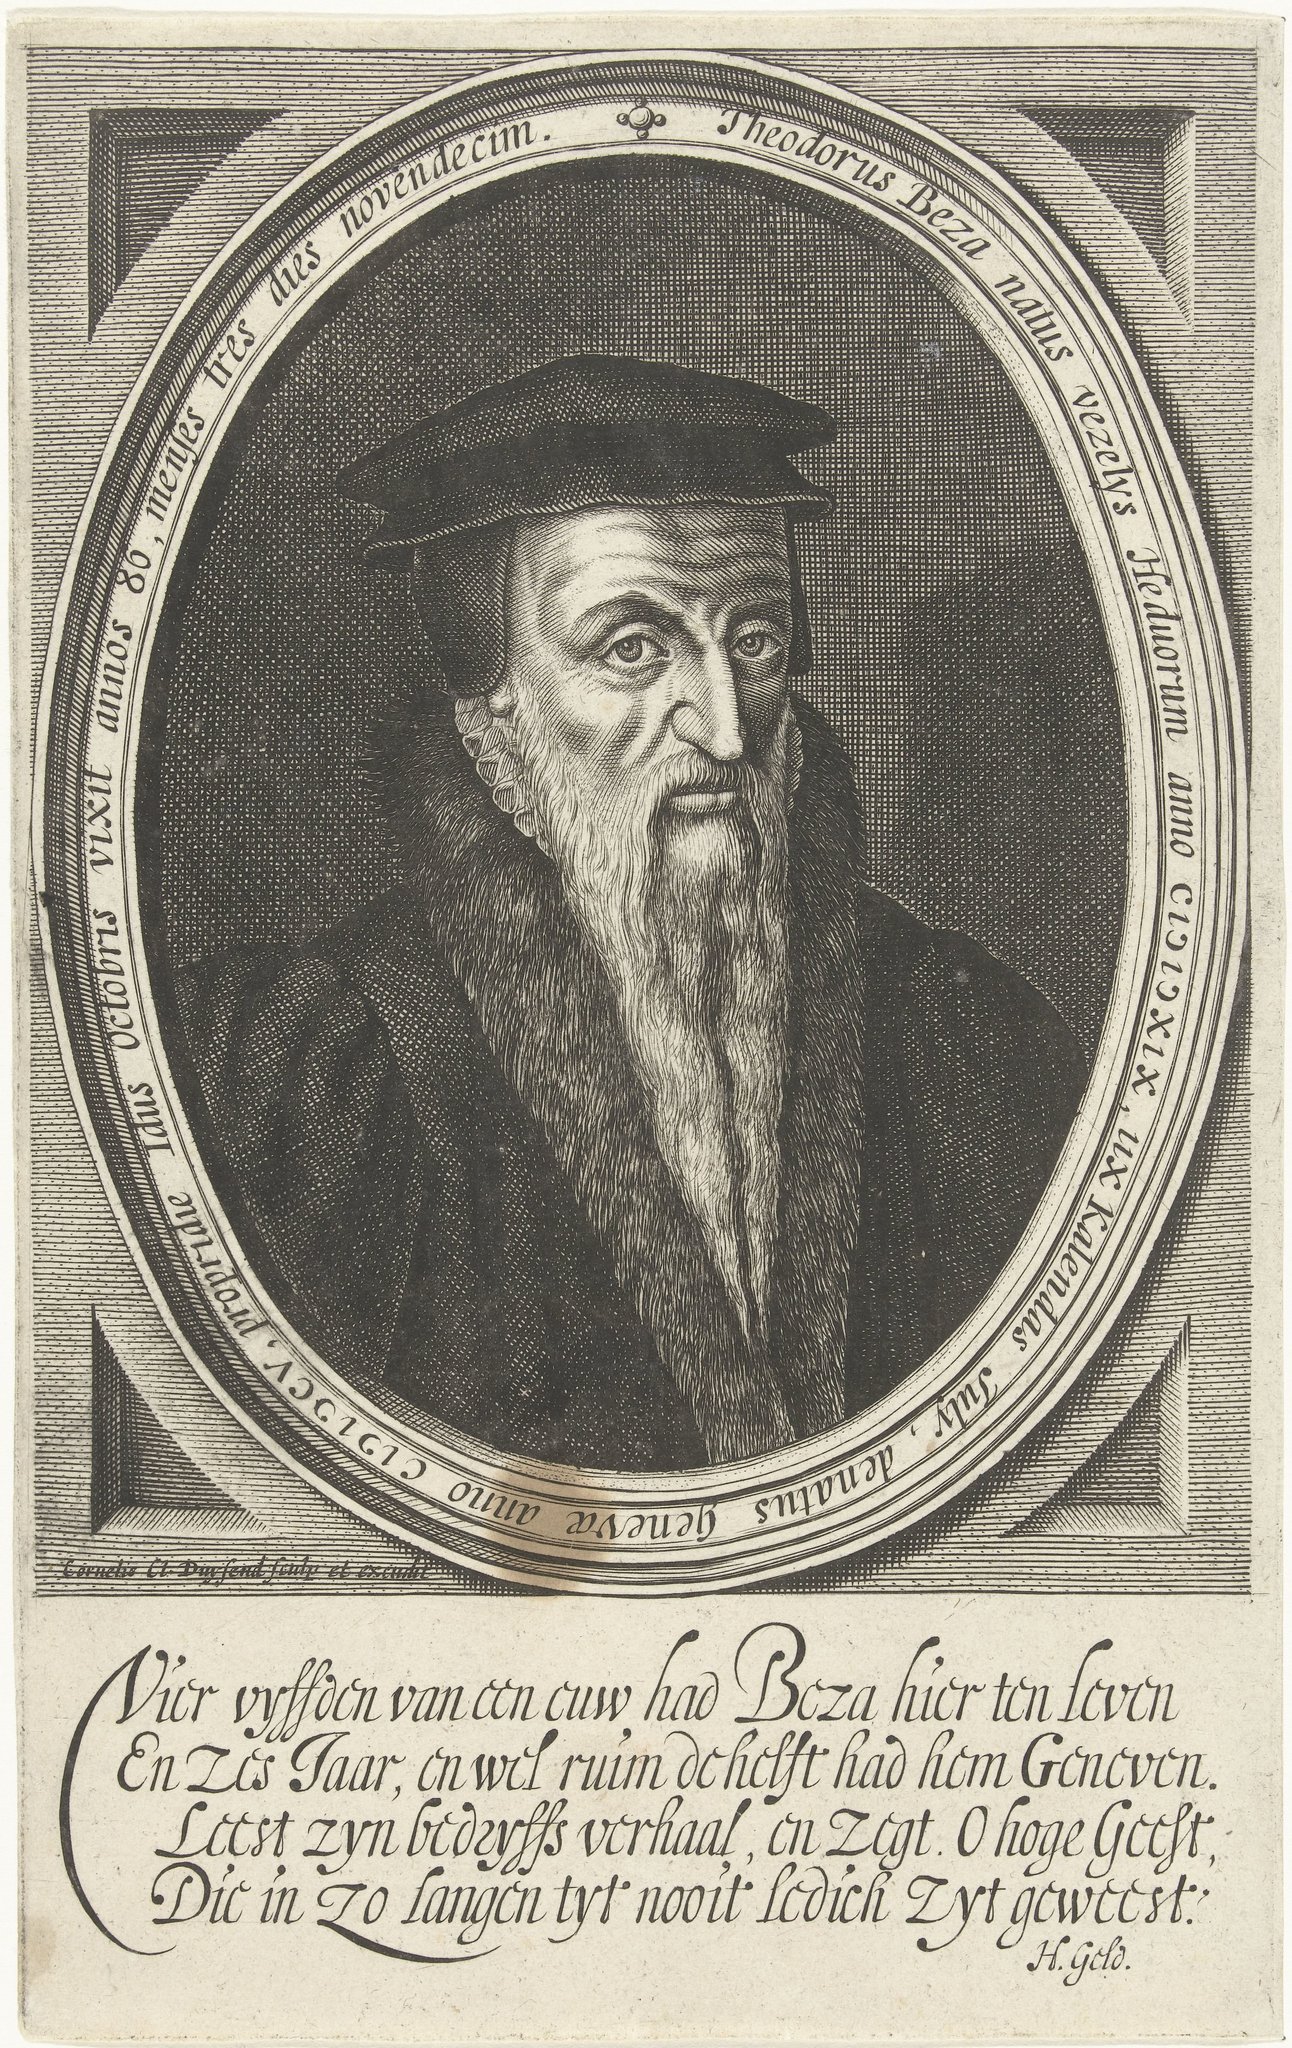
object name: print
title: Portret van Theodorus Beza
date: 1630-1641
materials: paper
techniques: engraving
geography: netherlands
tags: theodorus beza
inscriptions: collector's mark: Lugt 240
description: Portret van de reformator Theodorus Beza, in ovaal met randschrift. Onder het portret een vers in het Nederlands door Hendrik Geldorp.